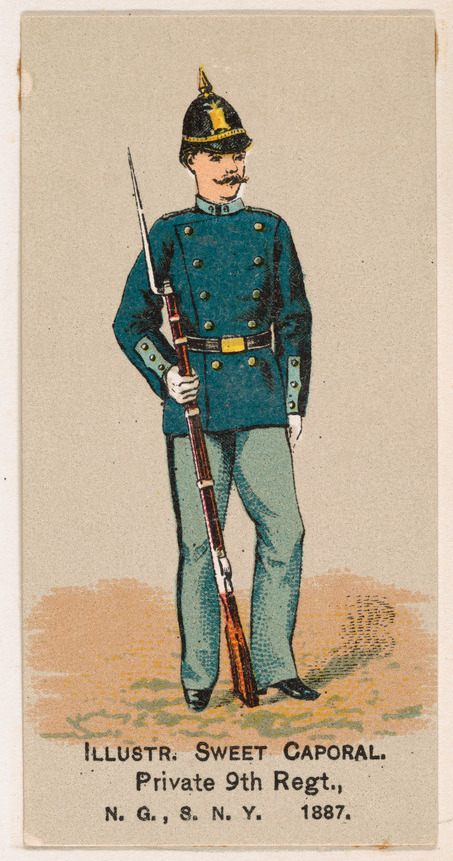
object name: print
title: Private, 9th Regiment, National Guard of the State of New York, from the Military Series (N224) issued by Kinney Tobacco Company to promote Sweet Caporal Cigarettes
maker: kinney brothers tobacco company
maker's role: publisher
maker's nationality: american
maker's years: 1869-2011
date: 1888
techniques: color lithograph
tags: military,firearms,men